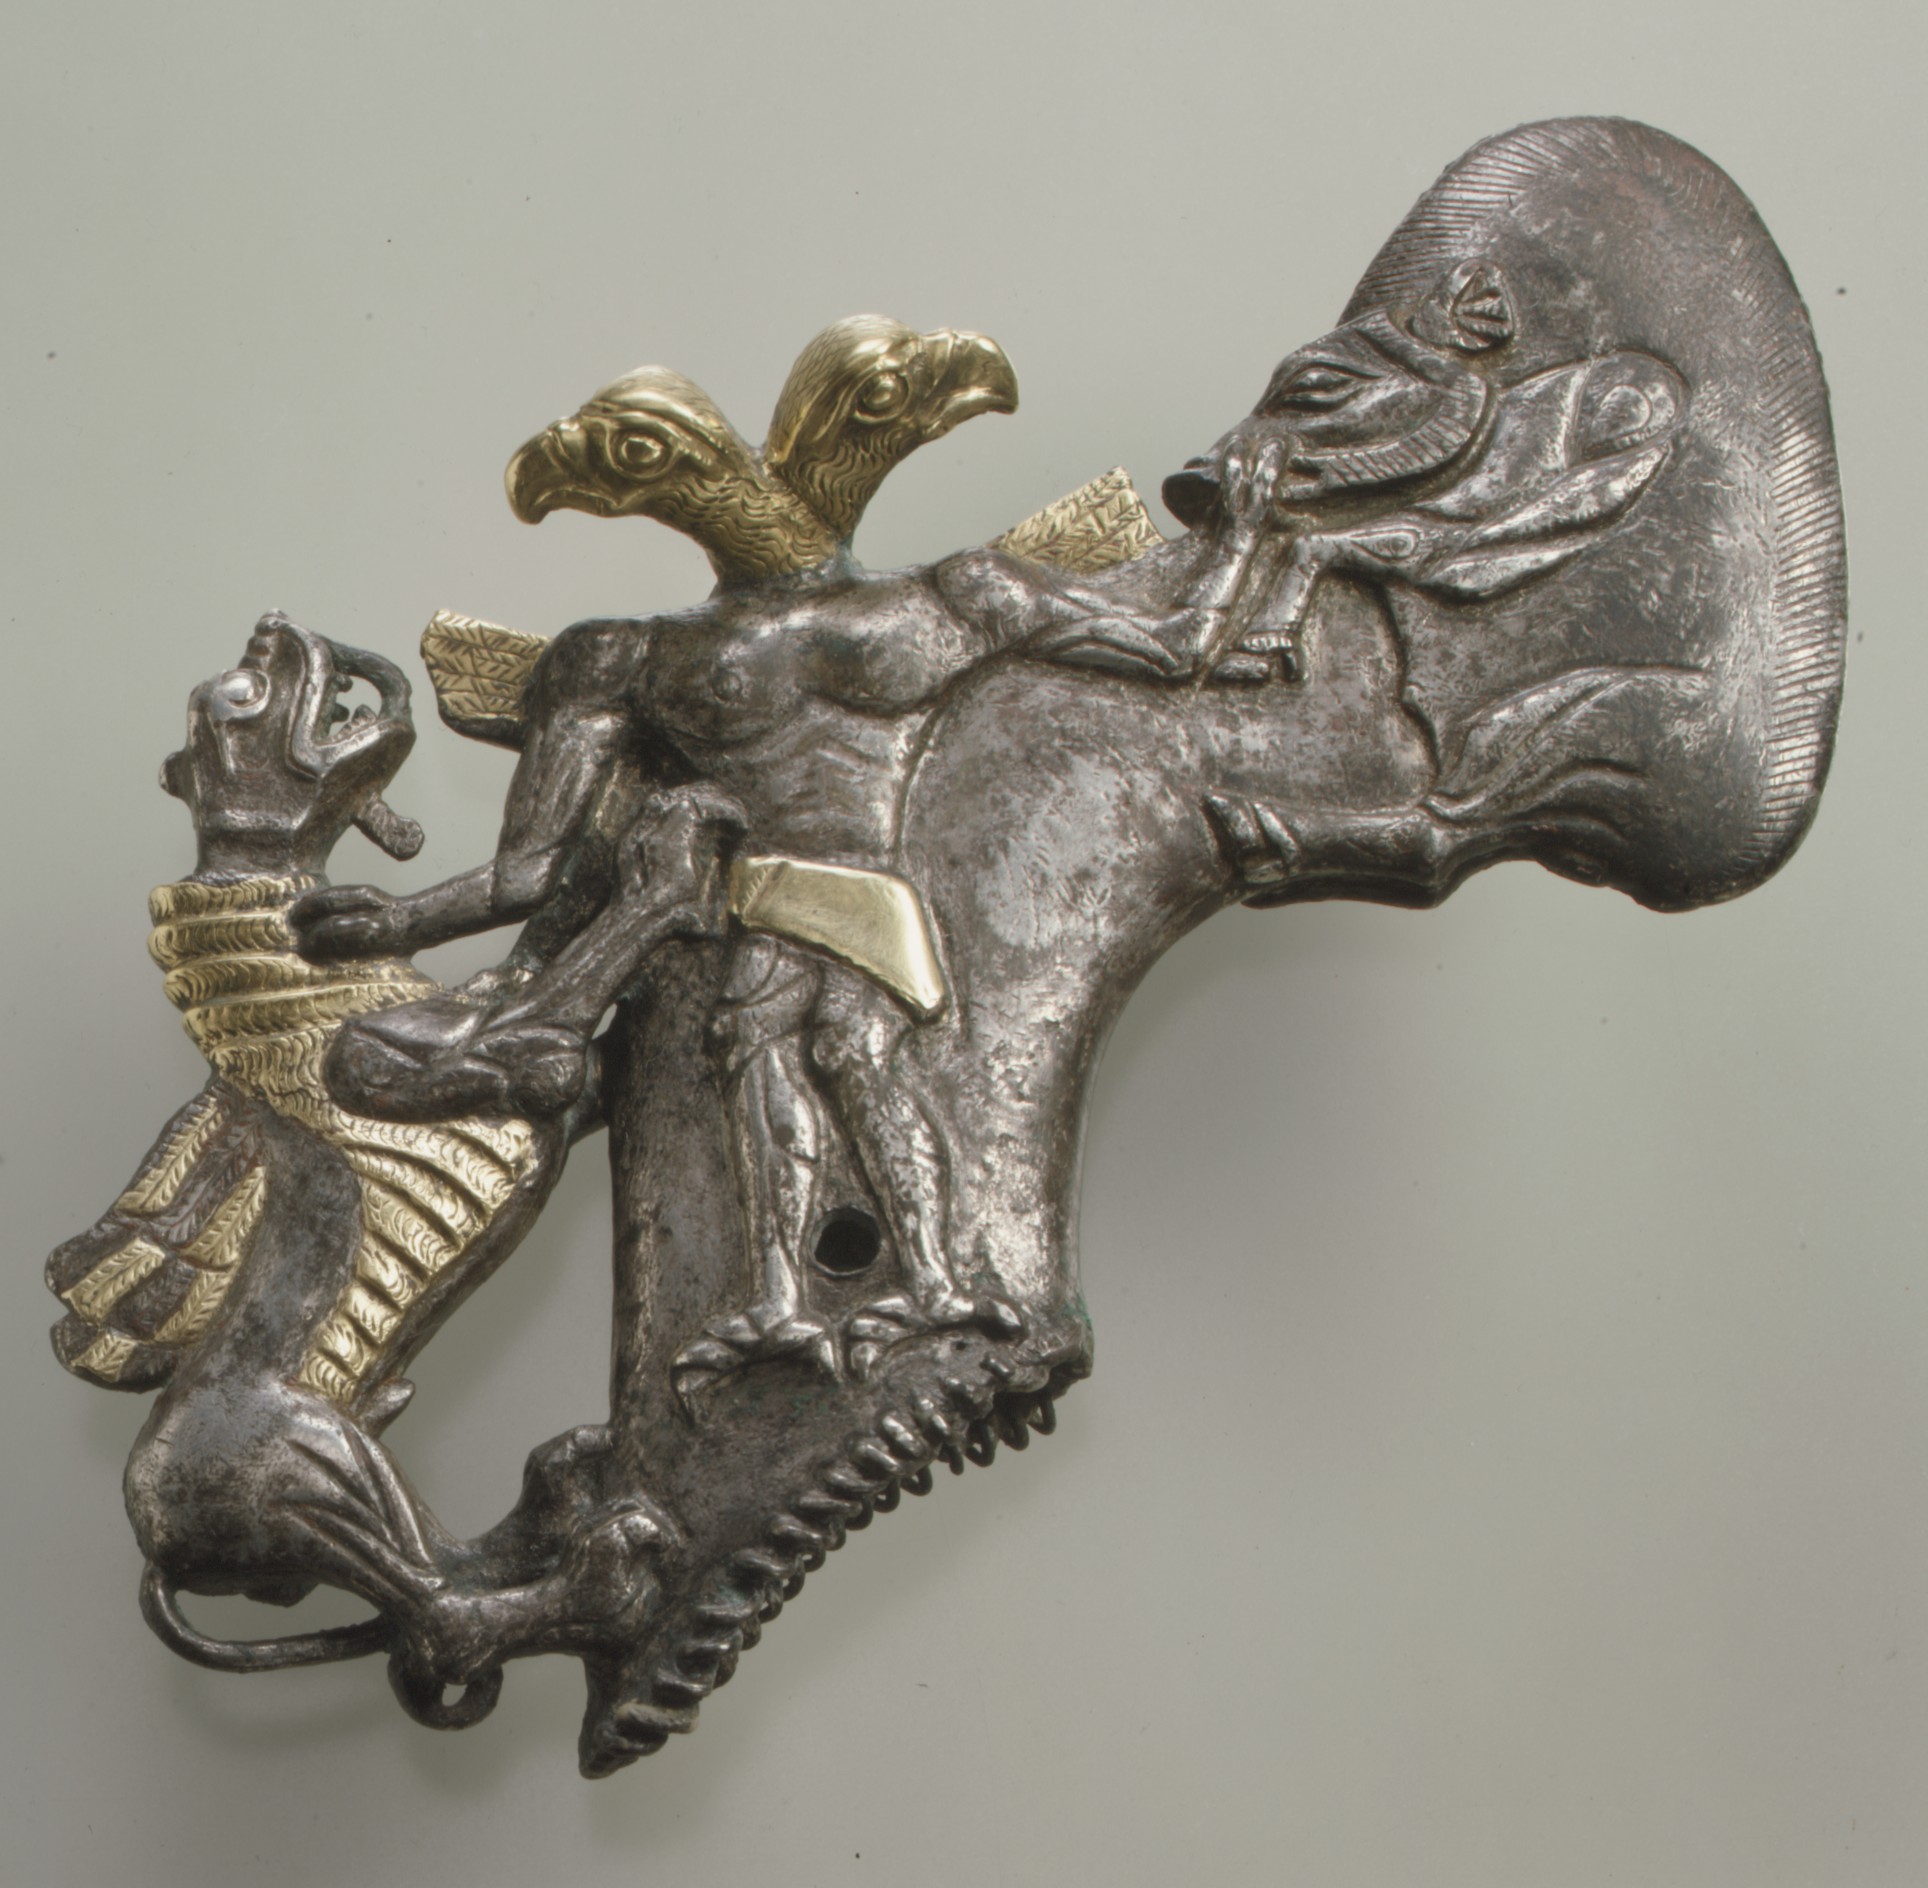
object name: axe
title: Shaft-hole axe head with bird-headed demon, boar, and dragon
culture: bactria-margiana archaeological complex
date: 2333-1668 BCE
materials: gold foil, silver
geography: bactria-margiana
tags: birds,dragons,boars,demons